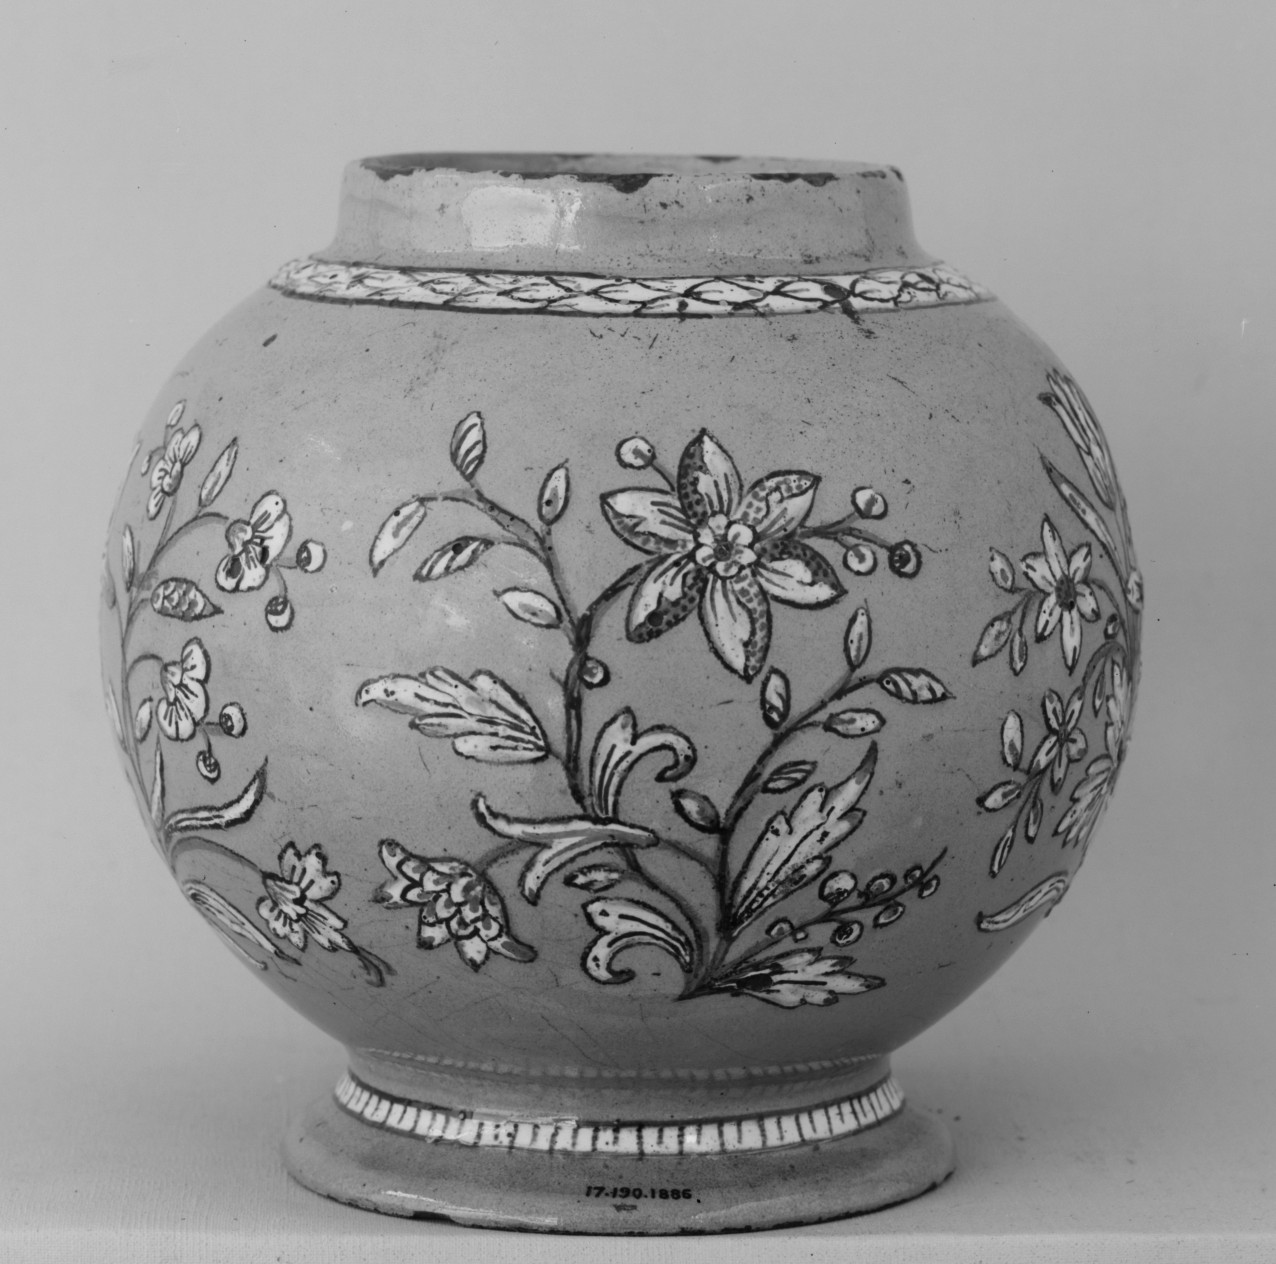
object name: vase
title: Vase (part of a set)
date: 1750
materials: faience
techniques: glazing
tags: flowers